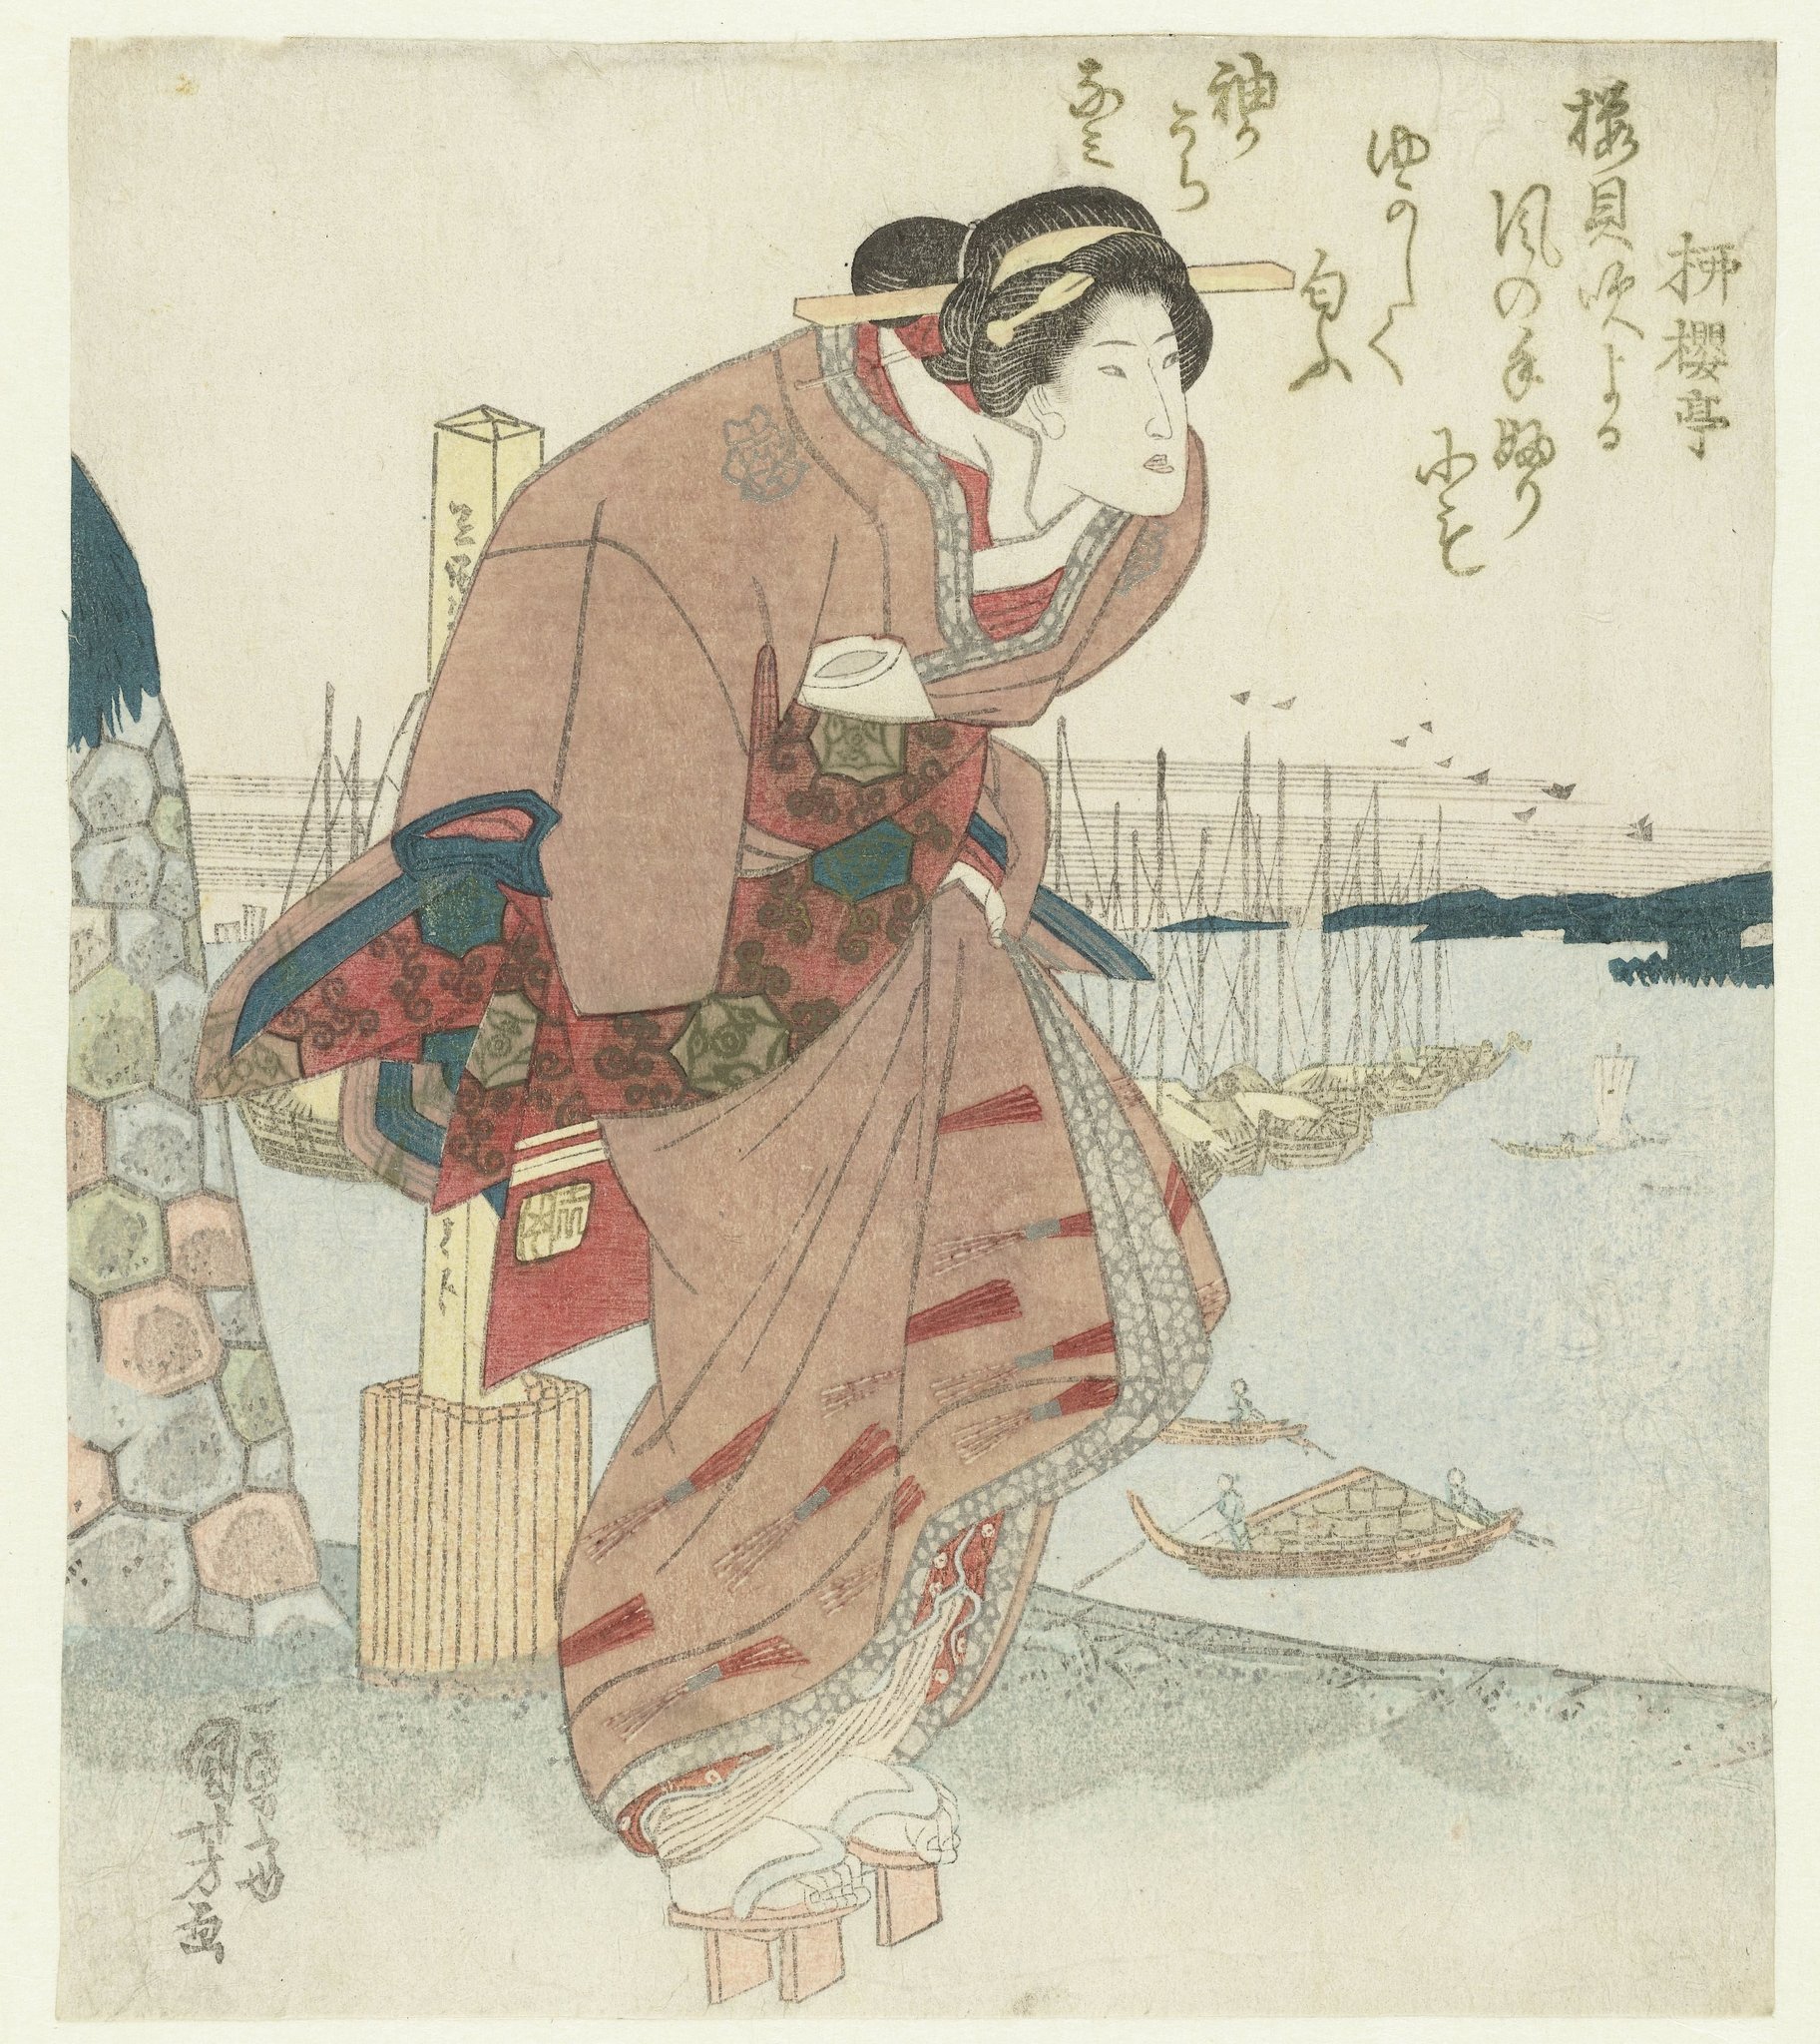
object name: surimono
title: Vrouw bij een haven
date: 1825-1830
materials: paper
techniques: blind stamped, woodcut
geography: japan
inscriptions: collector's mark, verso, stamped: Lugt 2228, collector's mark, passe-partout, bottom left, printed: JABdH with a rooster.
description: Een surimono is een luxe uitgevoerde prent waarop beeld met één of meerdere gedichten gecombineerd is. Bij het drukken van een surimono werd vaak gebruik gemaakt van dikker papier, blinddruk en metaal pigmenten, zoals koper- en zilverpoeder. De prenten werden vaak in opdracht van dichters gemaakt en als exclusief geschenk aan vrienden en relaties gegeven.